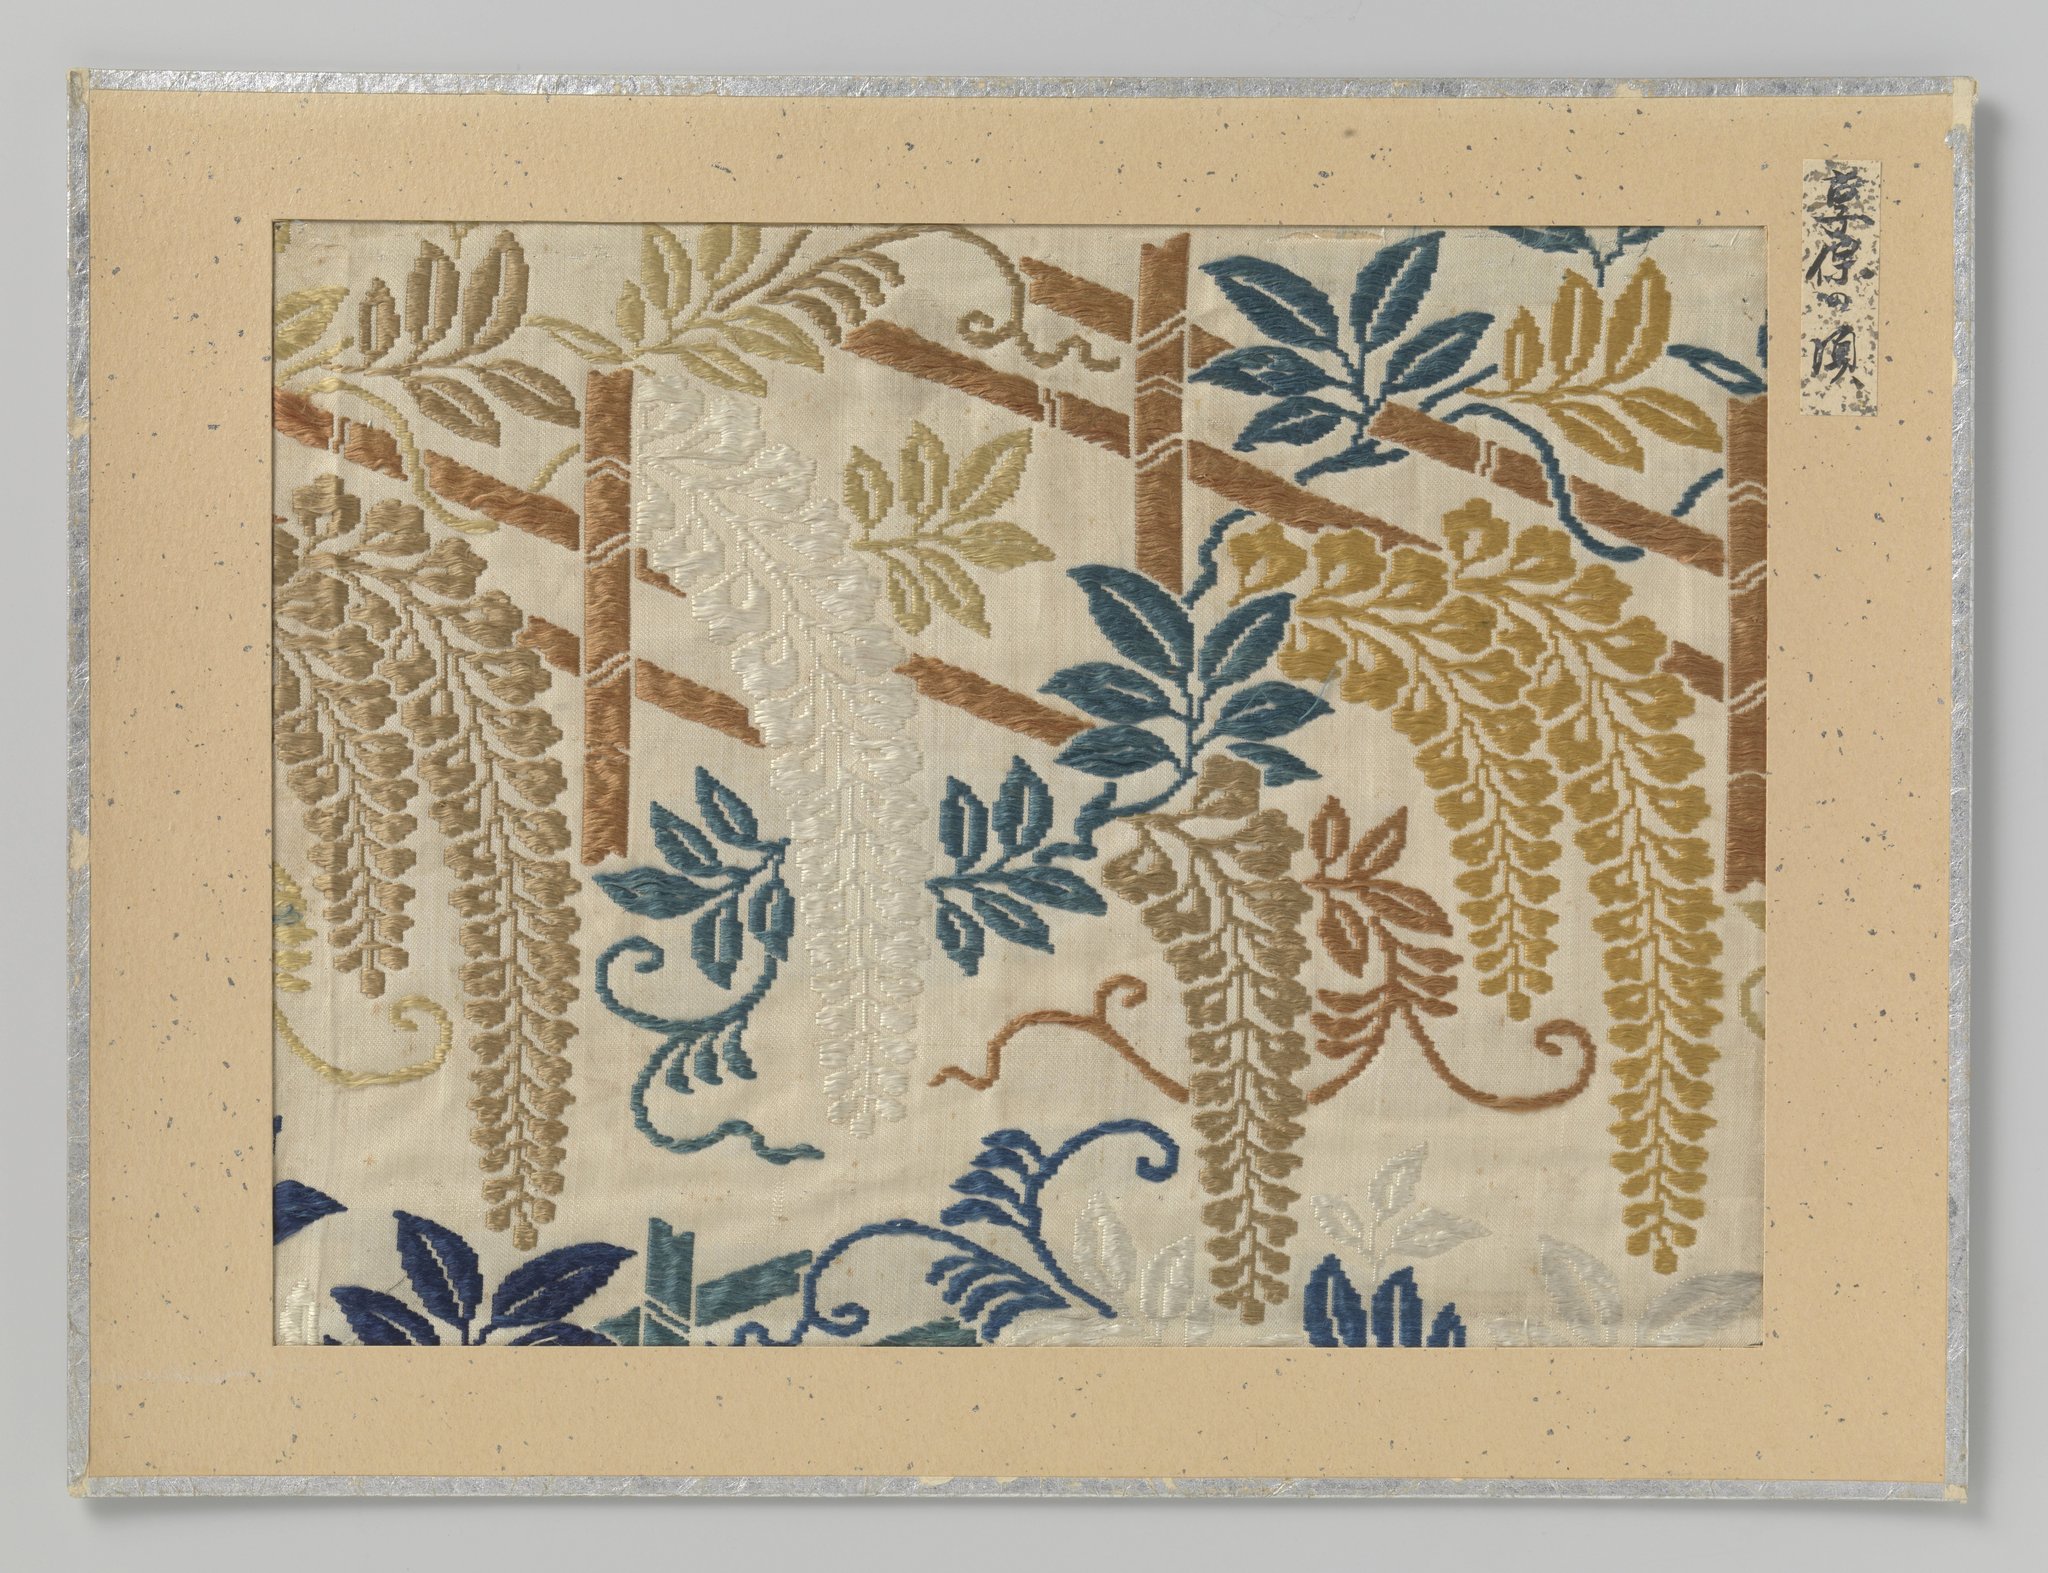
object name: textile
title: Fragment textiel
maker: Anonymous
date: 1716-1736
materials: silk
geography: japan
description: Textielfragment, borduursel van gouden regen.